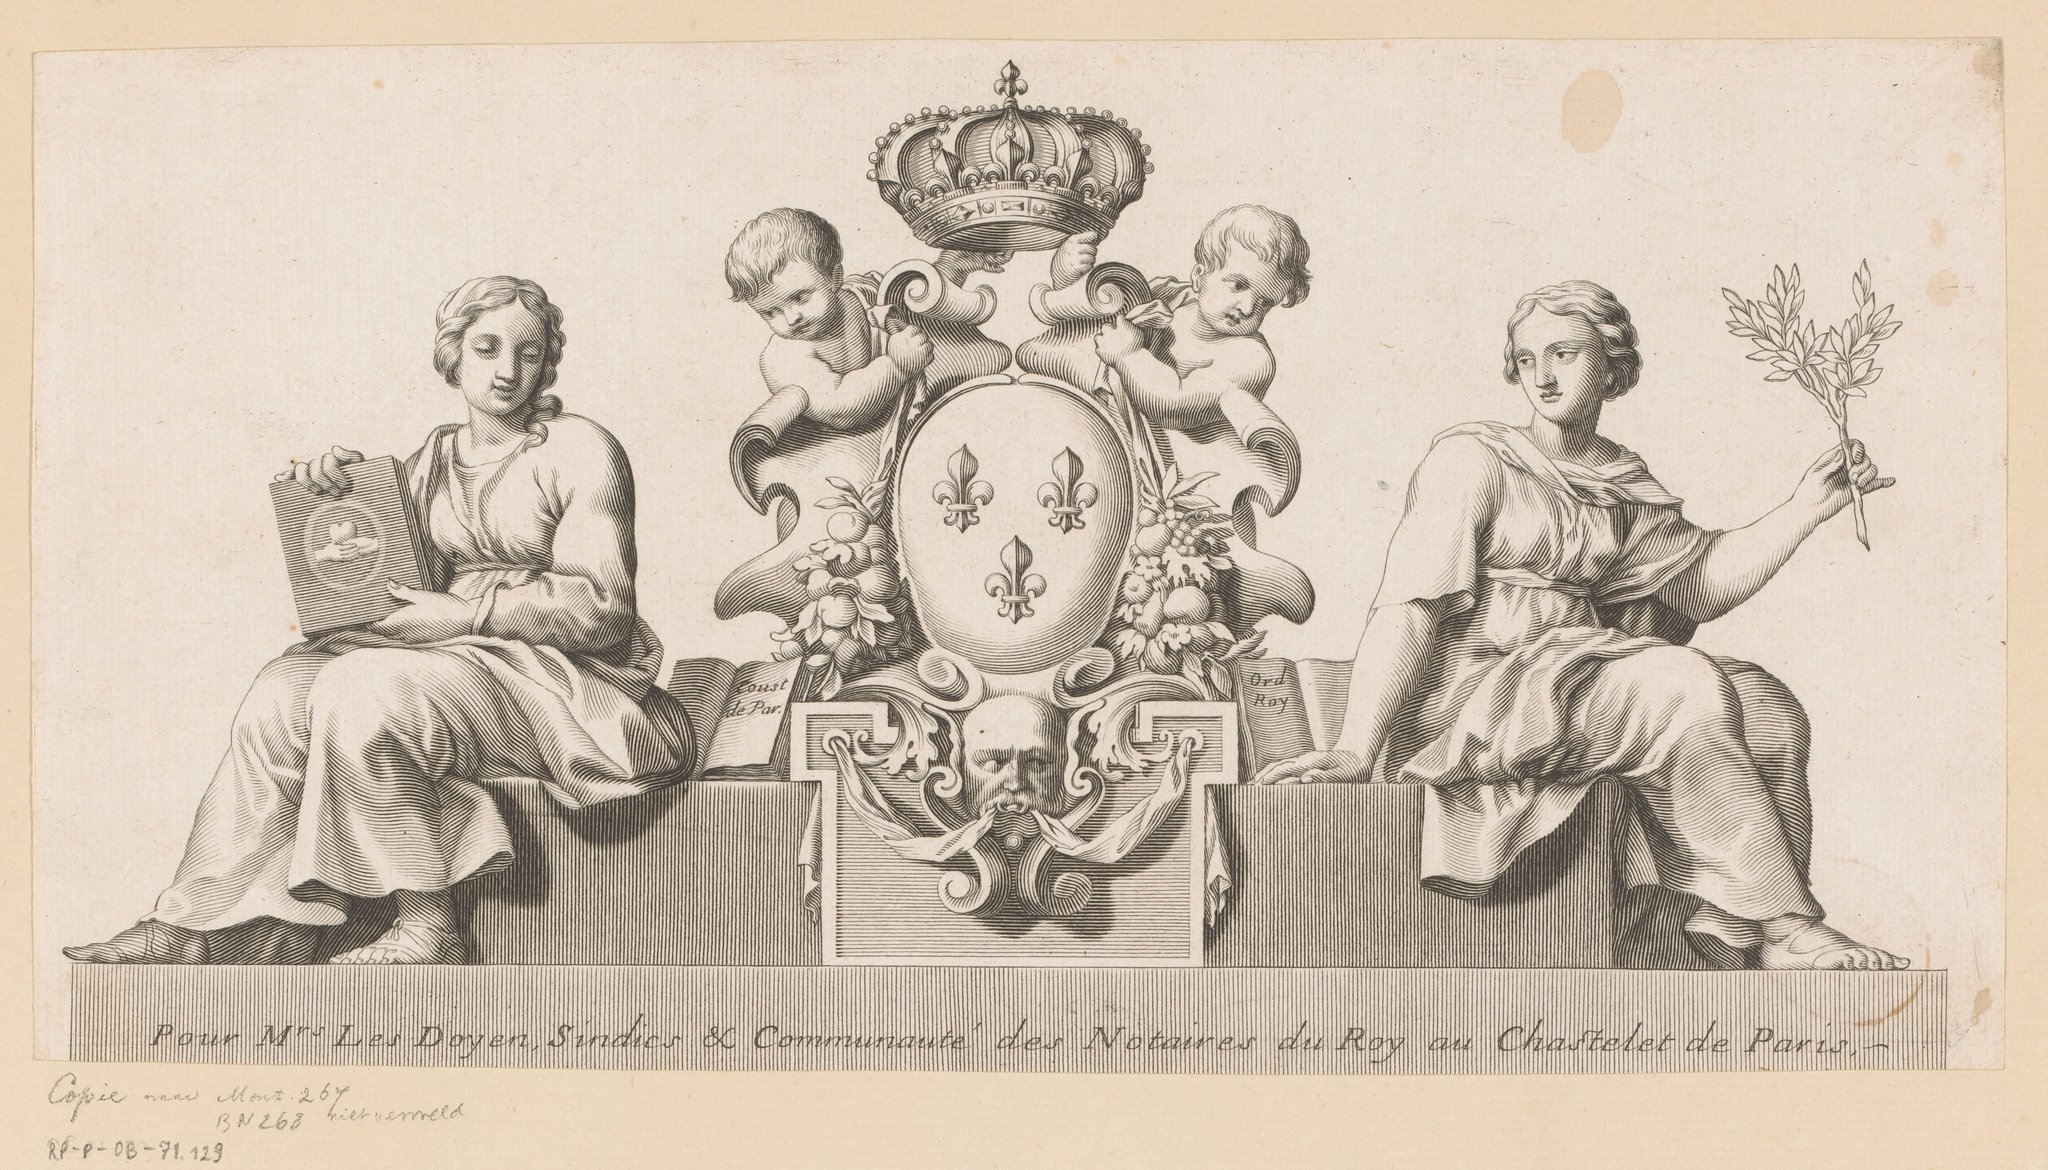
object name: print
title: Wapen van de notarissen van het Châtelet in Parijs met personificaties van het Goede Geloof en de Wet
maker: Anonymous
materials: paper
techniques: engraving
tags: armorial bearing, heraldry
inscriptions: collector's mark: Lugt 240